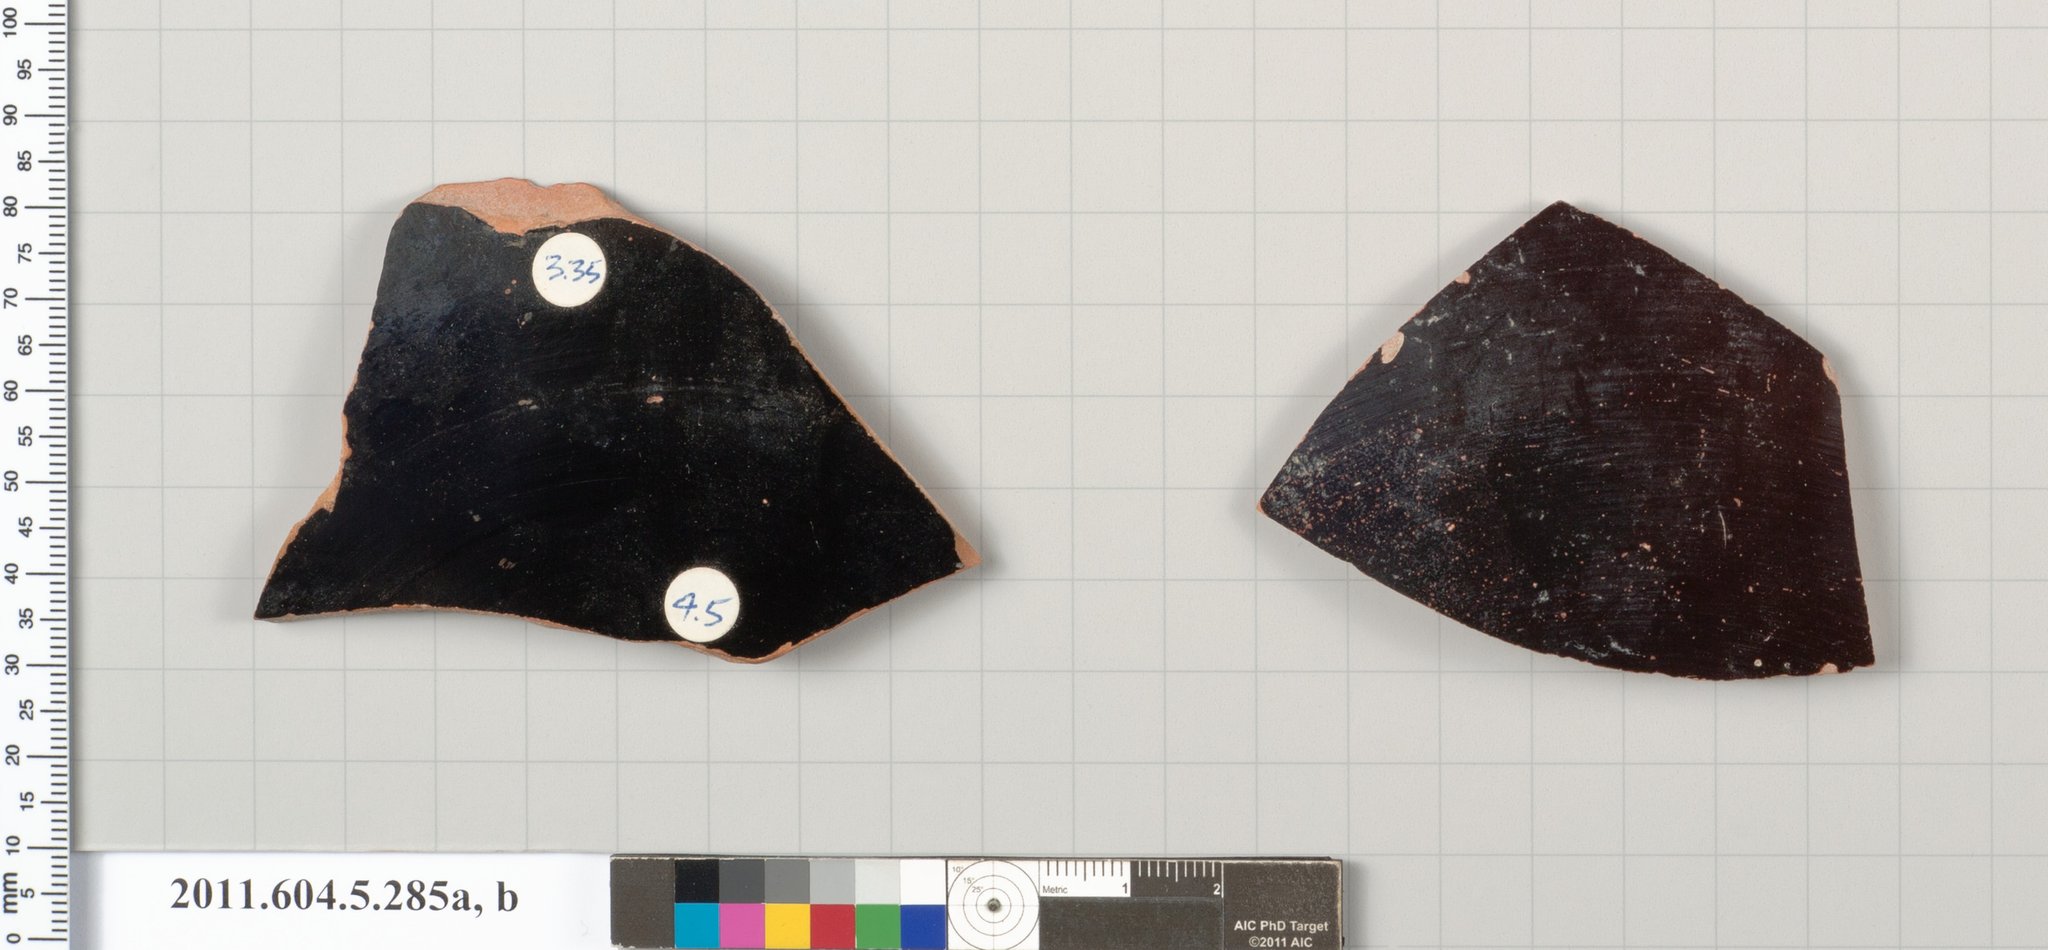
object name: kylix fragment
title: Terracotta fragments of kylikes (drinking cups)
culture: greek, attic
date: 600-401 BCE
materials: terracotta